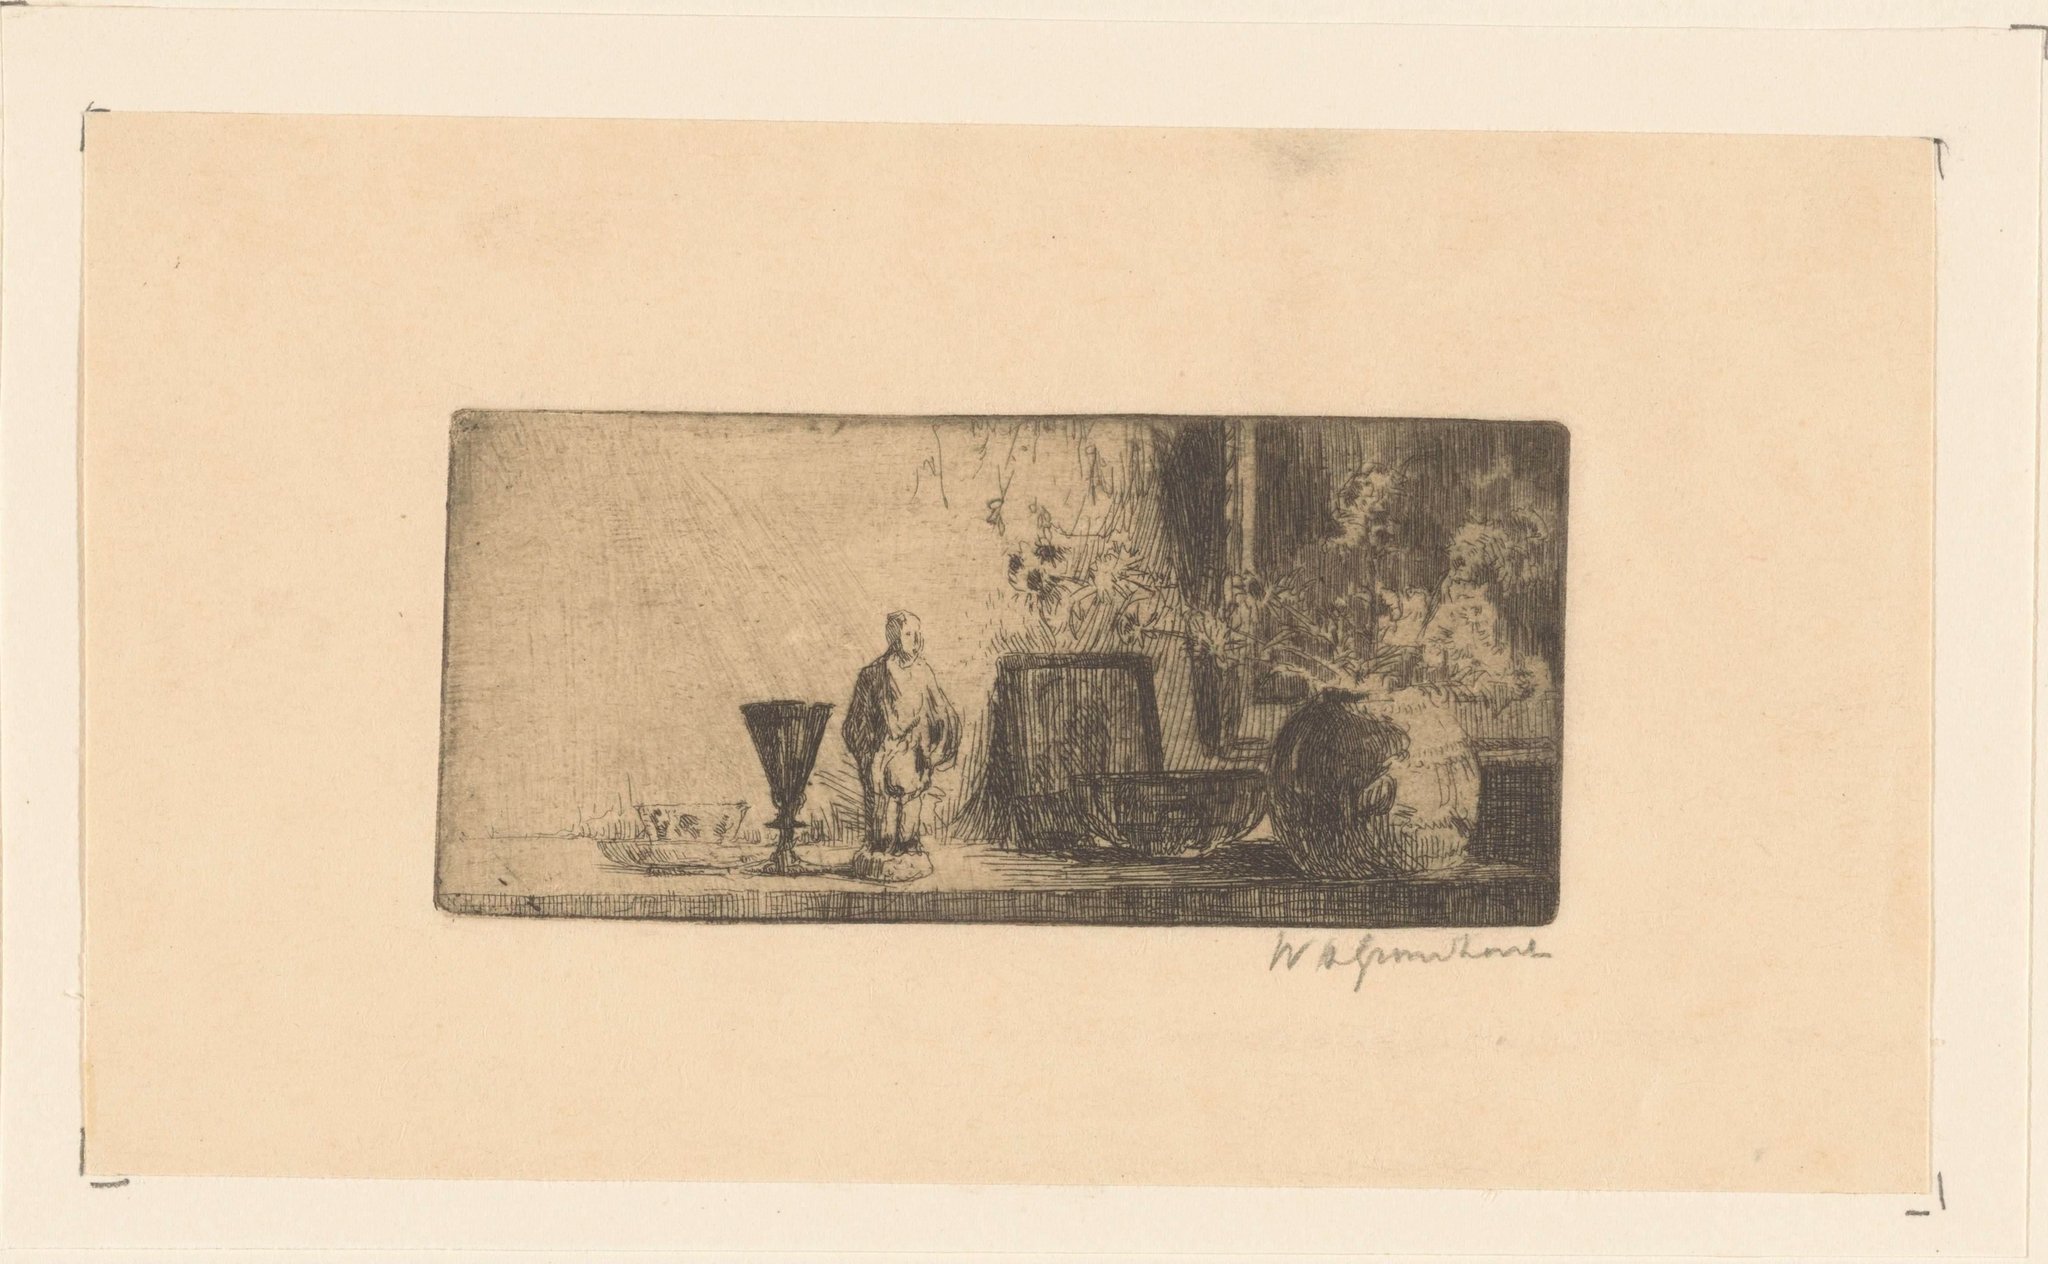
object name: print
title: Stilleven met bloemen in een gemberpot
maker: willem adrianus grondhout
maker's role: draughtsman, painter, print maker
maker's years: 1878-1934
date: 1888-1934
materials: paper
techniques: etching, intaglio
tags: still life of miscellaneous objects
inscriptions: collector's mark: Lugt 2228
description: Links van de gemberpot een wijnglas en een beeld.